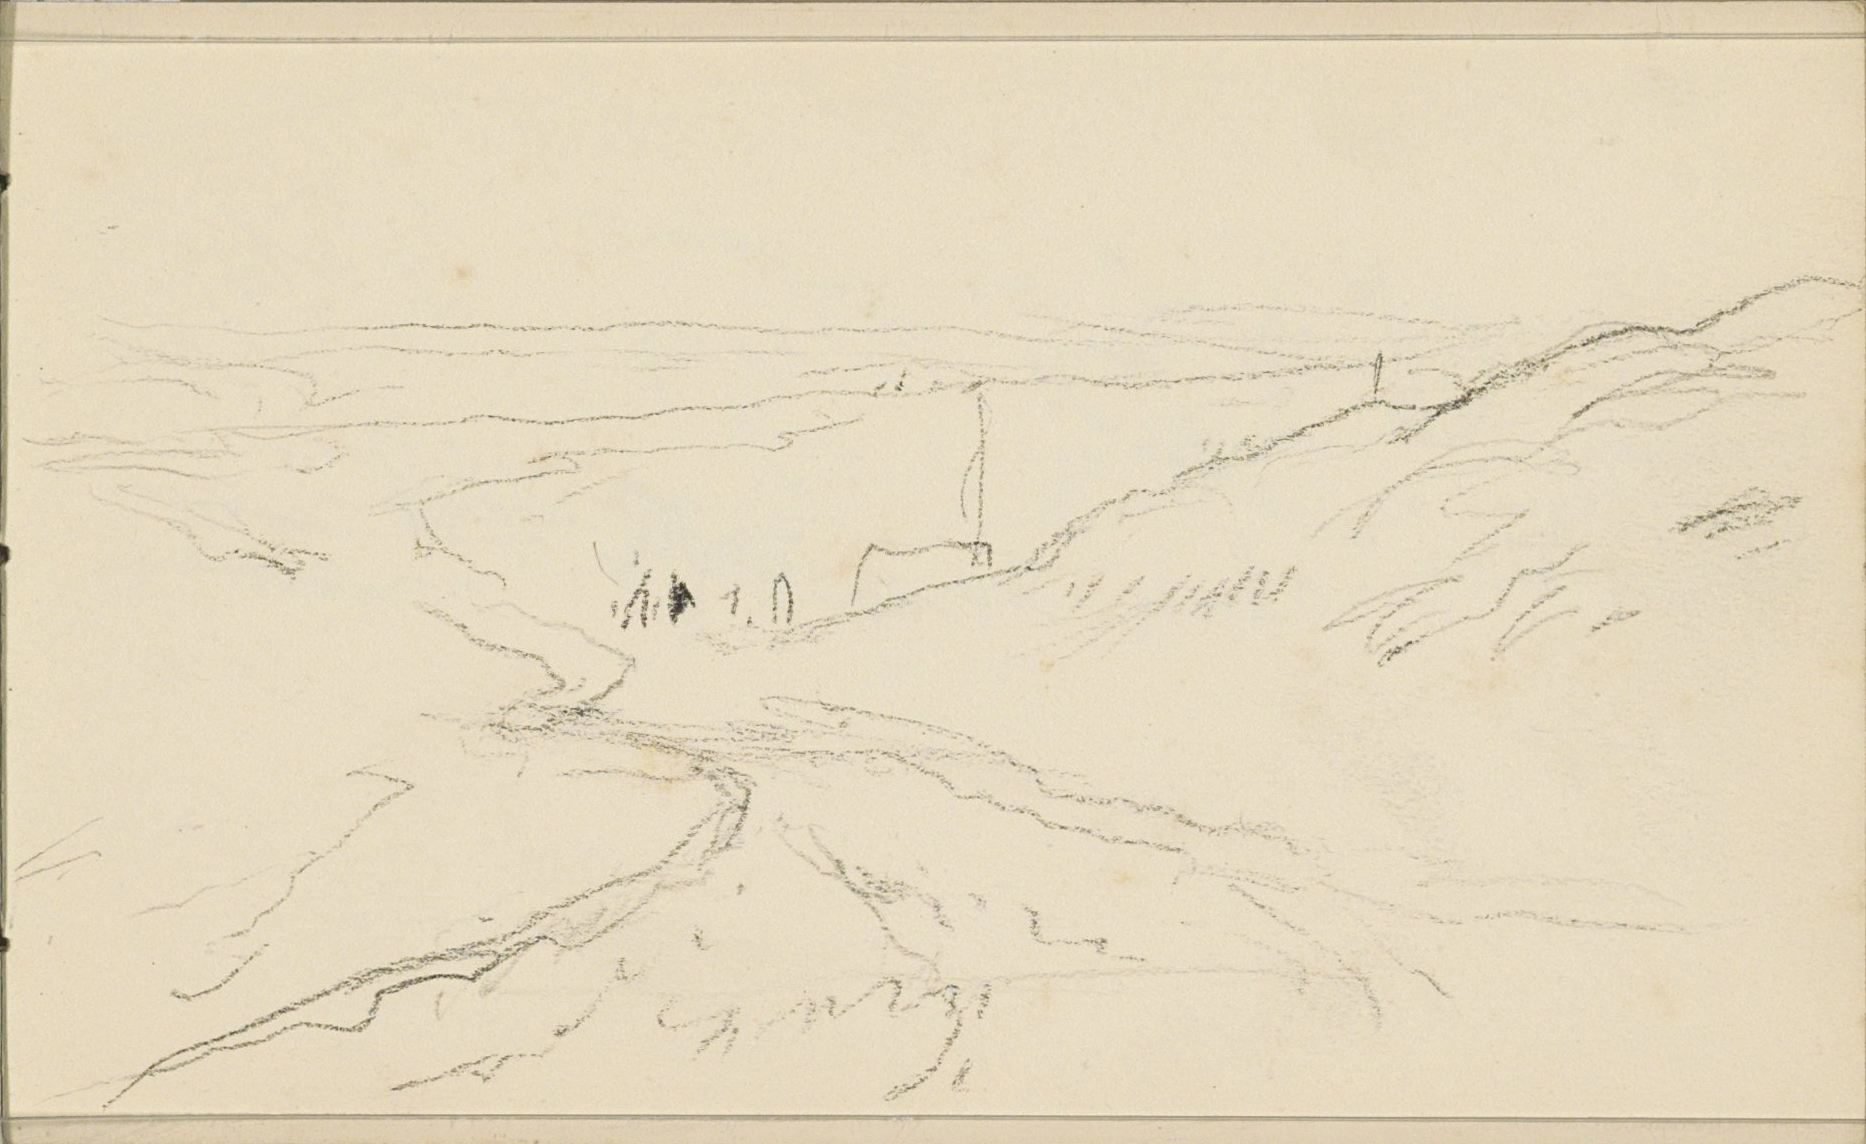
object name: sketchbook leaf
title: Pad in de duinen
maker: anton mauve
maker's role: draughtsman, painter, print maker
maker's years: 1838-1888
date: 1876-1888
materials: chalk, paper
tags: dunes (sea not visible); in the dunes, road, path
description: Blad 11 recto uit een schetsboek met 34 bladen.